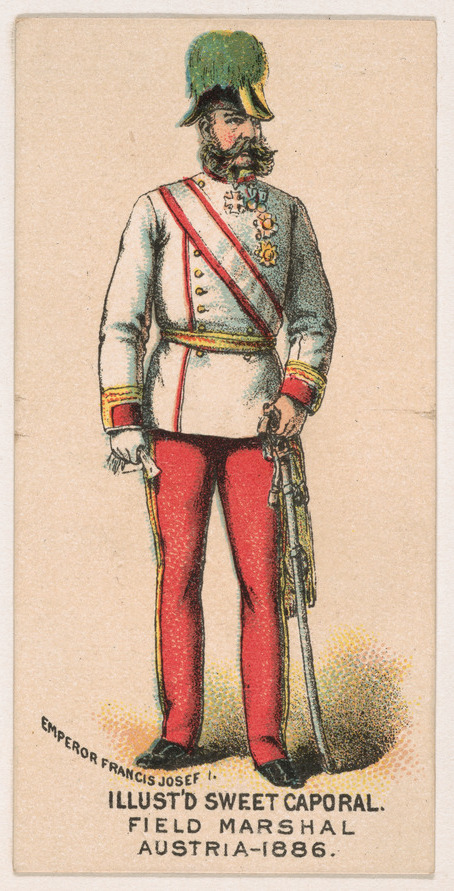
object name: print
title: Field Marshal, Austria, 1886, from the Military Series (N224) issued by Kinney Tobacco Company to promote Sweet Caporal Cigarettes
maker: kinney brothers tobacco company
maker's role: publisher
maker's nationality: american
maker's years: 1869-2011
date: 1888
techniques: color lithograph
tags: military,swords,men